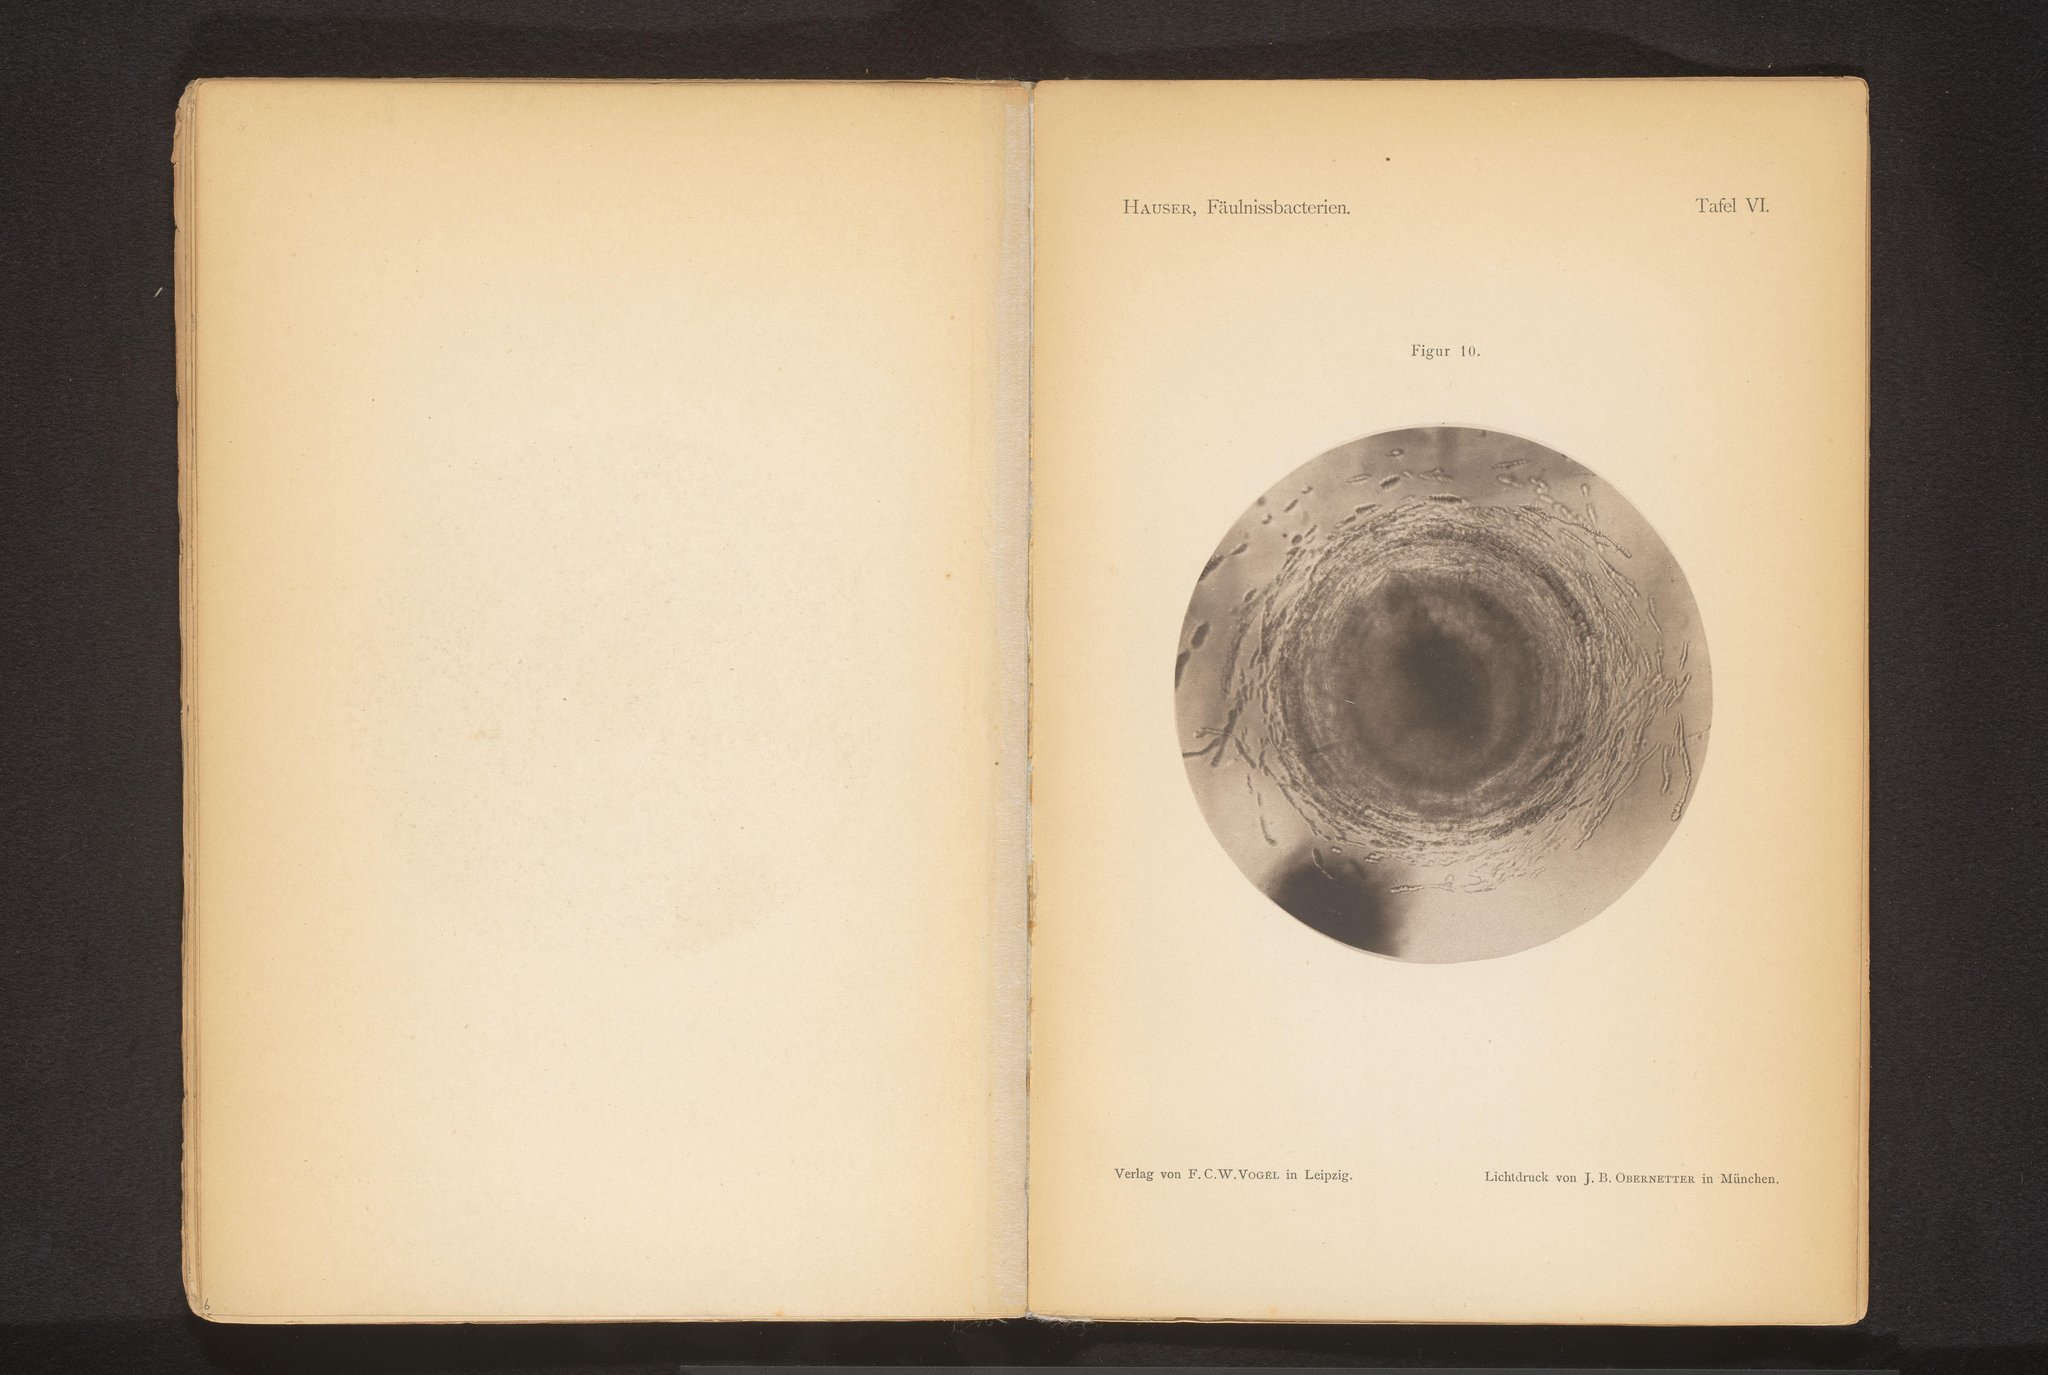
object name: page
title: Microscoopopname van bederfbacteriën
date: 1875-1885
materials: paper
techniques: photograph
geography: munich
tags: unicellular animals, bacteria, bacilli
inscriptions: number: ‘Tafel VI. Figur 10.’